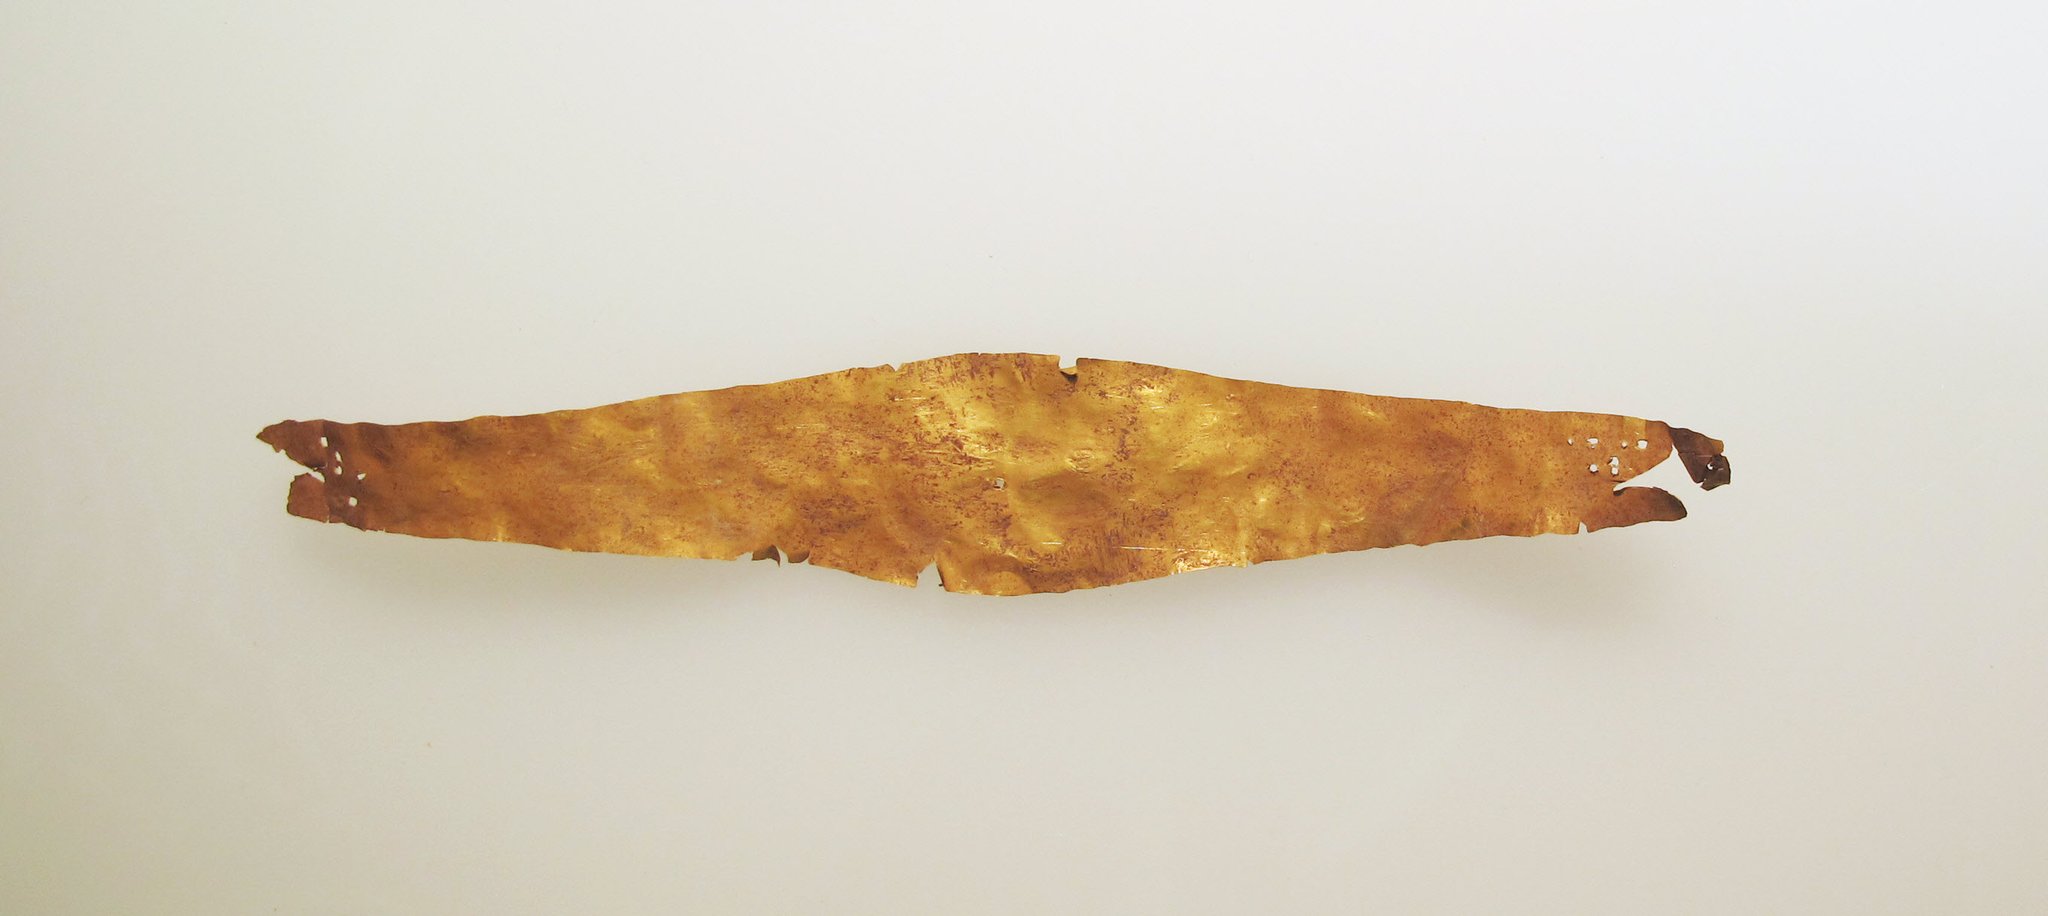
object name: frontlet of gold leaf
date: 7000 BCE-330 CE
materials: gold